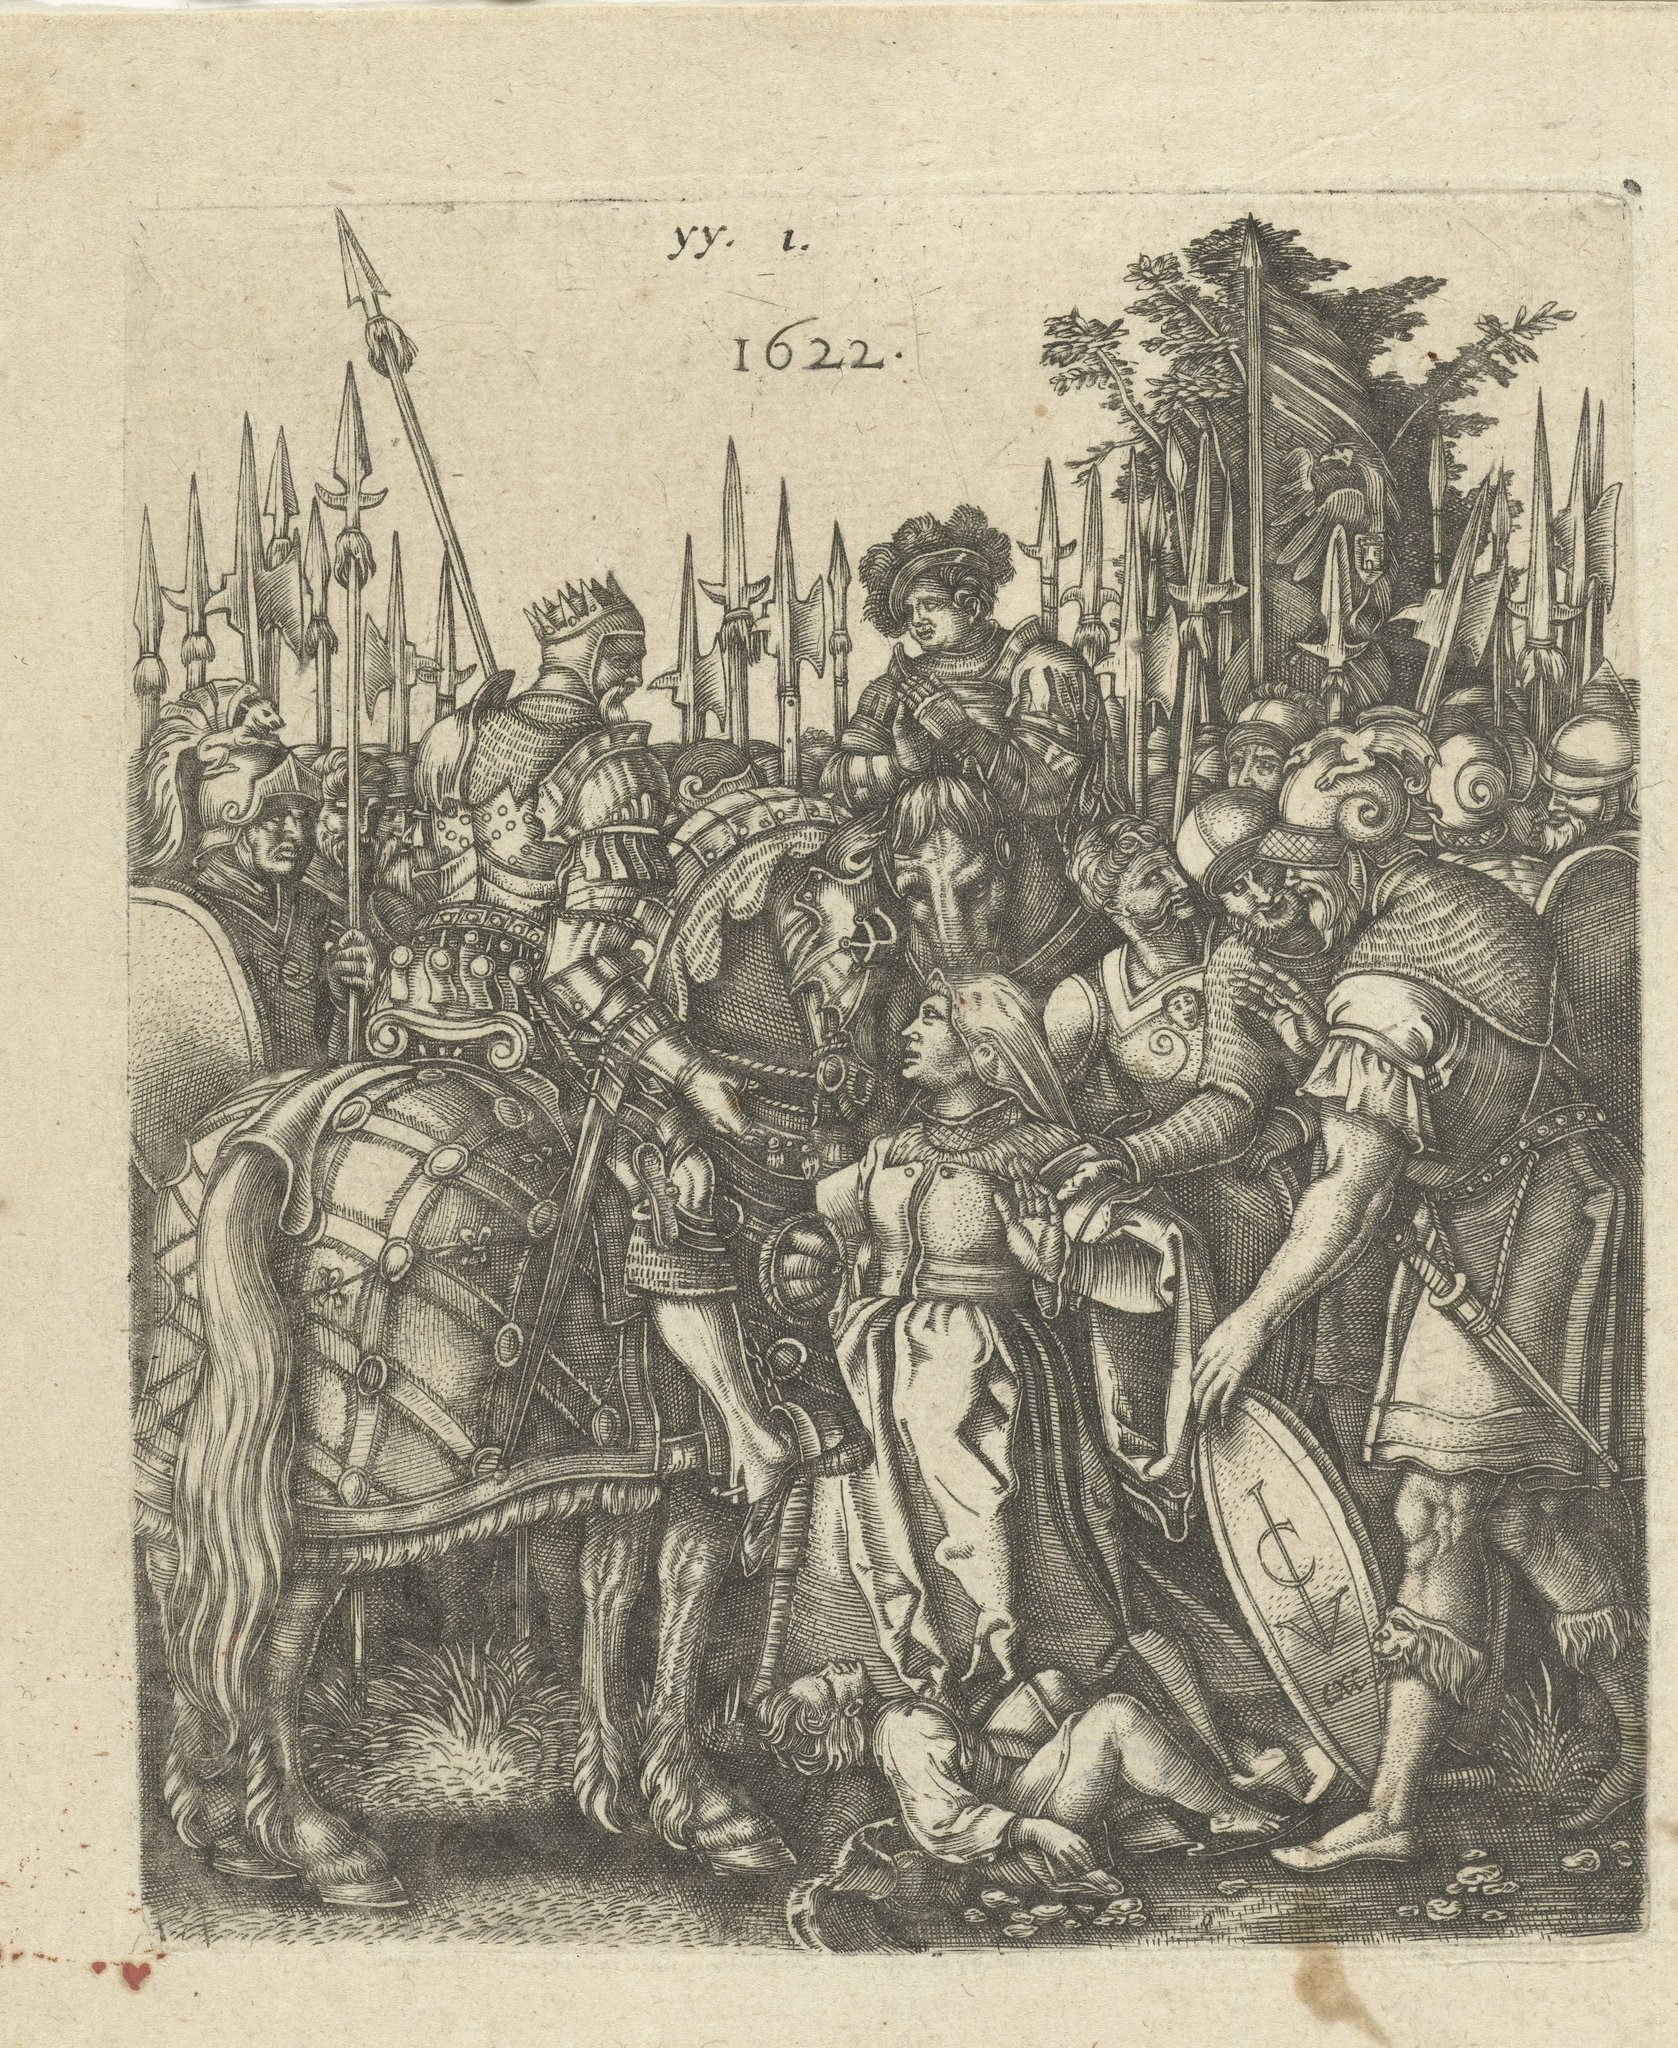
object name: print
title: Gerechtigheid van Trajanus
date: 1622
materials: paper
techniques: engraving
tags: the emperor riding out is stopped by the mother of the dead baby ~ justice of trajan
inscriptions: collector's mark: Lugt 240, collector's mark: Lugt 2228a, number: ‘yy. 1.’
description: kopie in spiegelbeeld naar een prent van Hans Sebald Beham op een groter formaat. De zoon van een weduwe is gedood door een soldaat van keizer Trajanus. Knielend bij het dode lichaam van haar zoon wijst ze de keizer op dit onrecht.